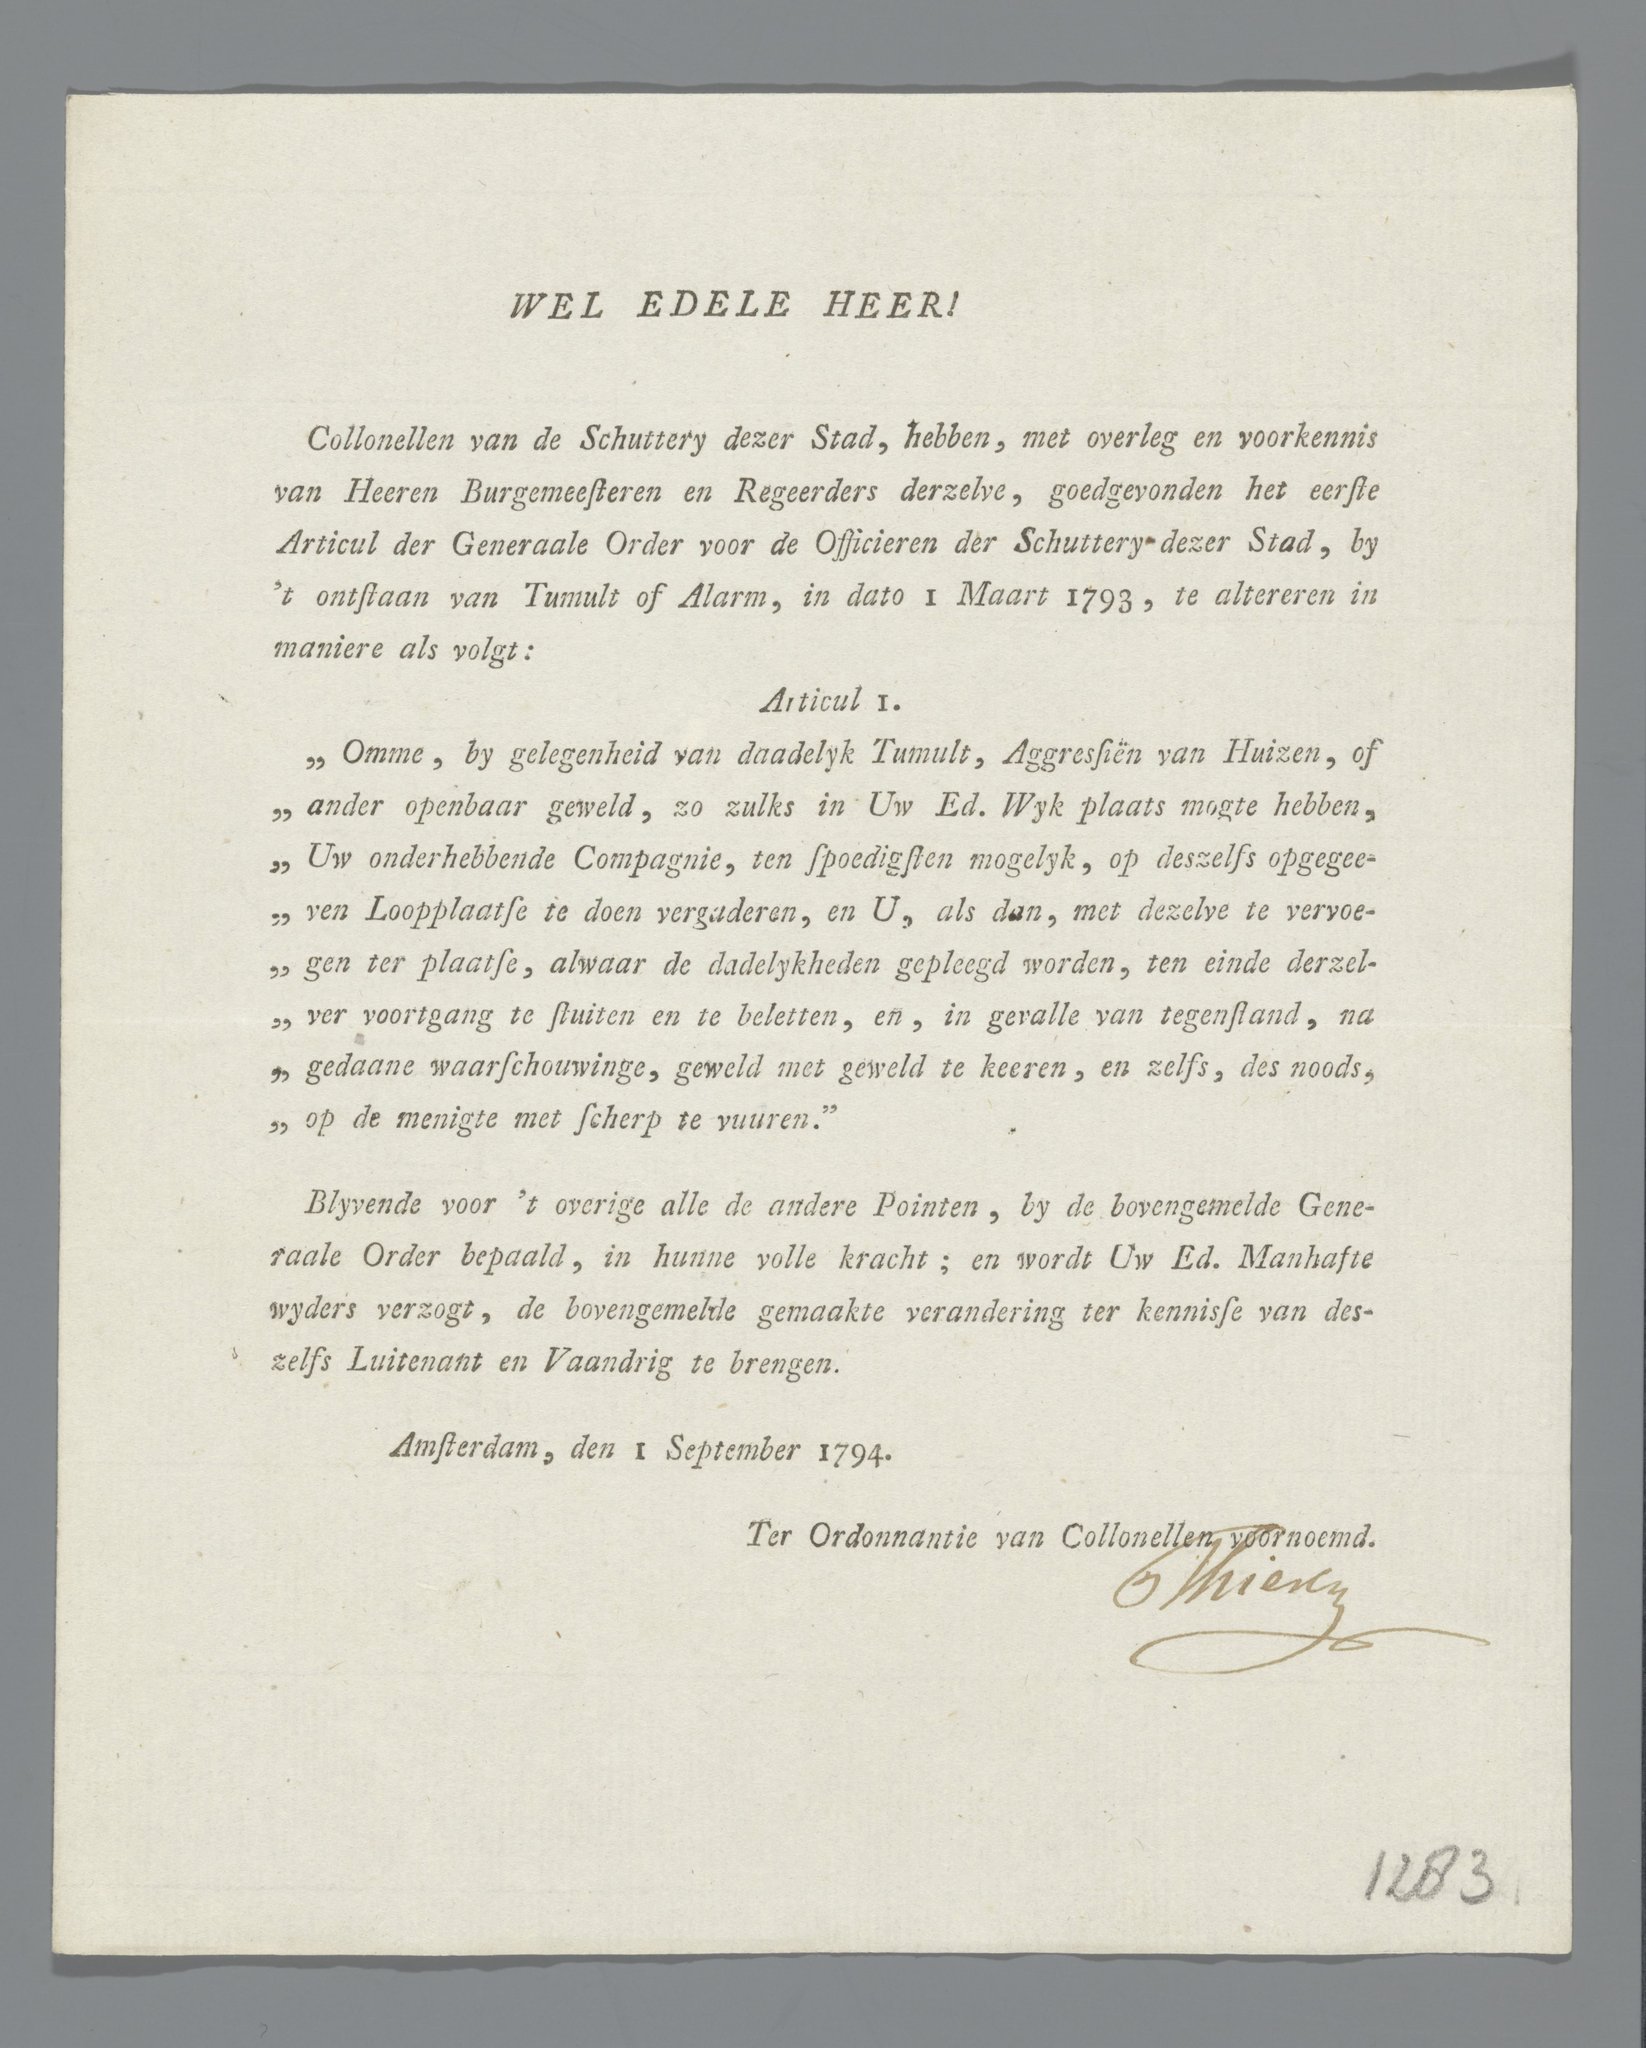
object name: document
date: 1794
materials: paper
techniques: printing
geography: amsterdam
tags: netherlands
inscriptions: date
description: Gedrukte brief, een zijde van een dubbelgevouwen blad beschreven, waarin de vernadering van artikel 1 van de "Generaale Order" voor de Amsterdamse schutterij-officieren gewijzigd worden bij alarmtoestanden. Gesigneerd en gedateerd.